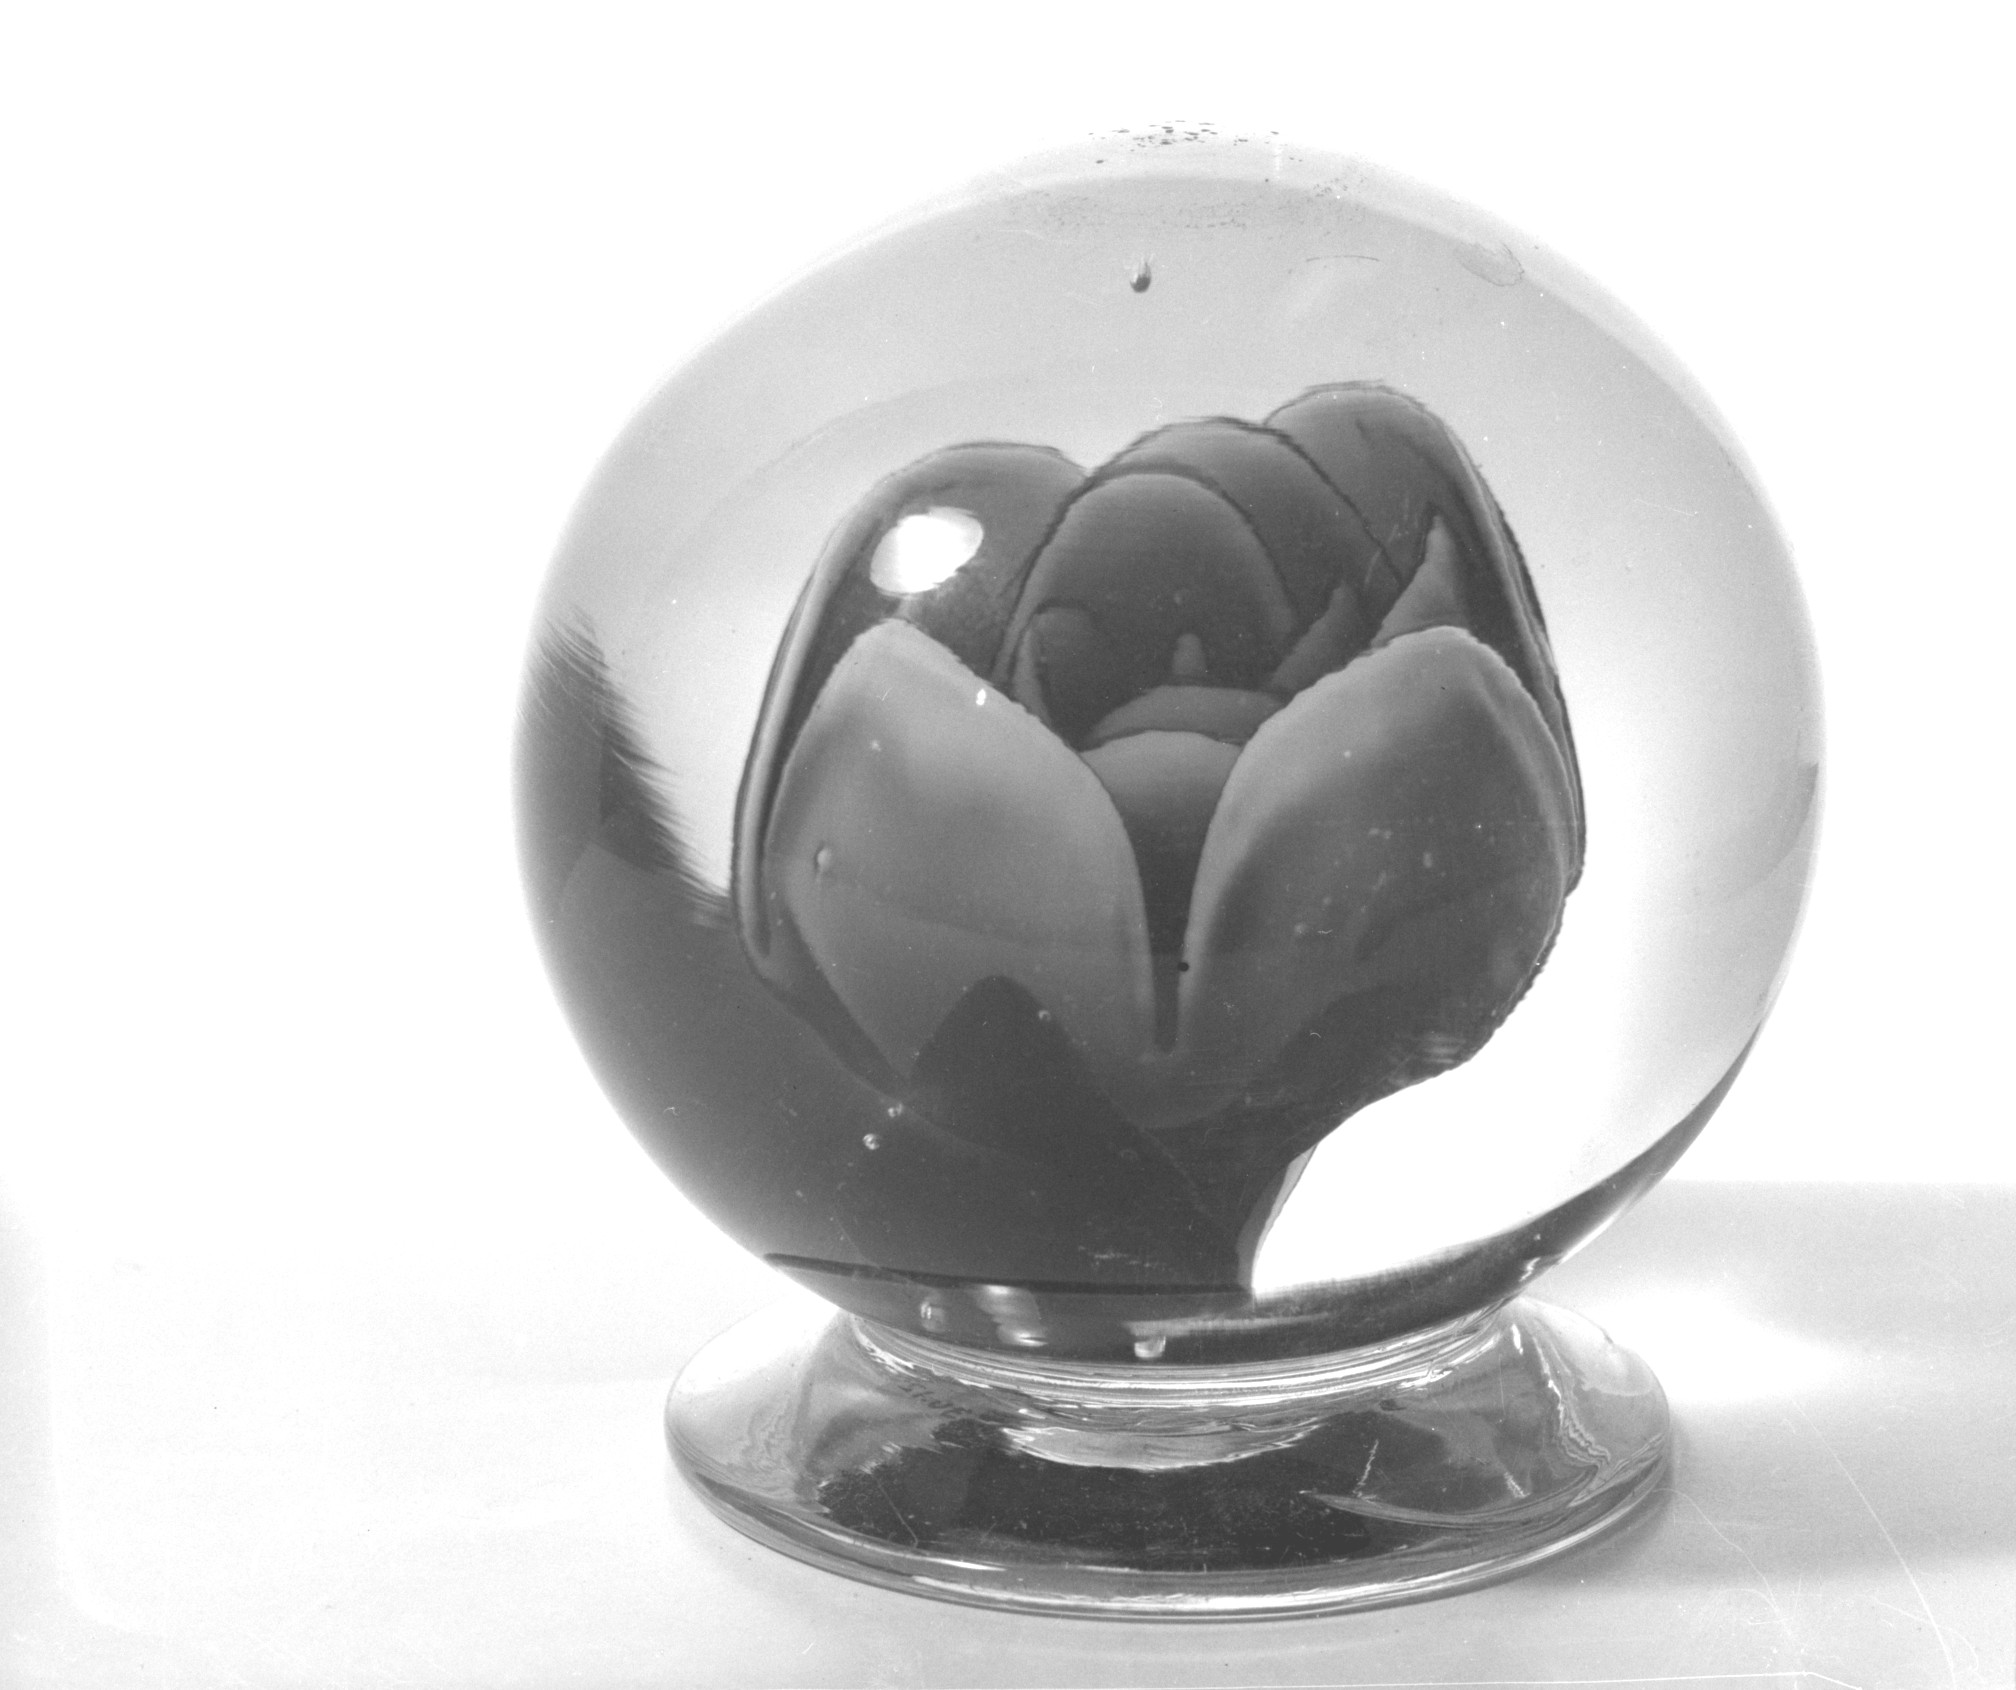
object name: paperweight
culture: american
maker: mount washington glass company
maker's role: maker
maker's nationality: american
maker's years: 1837-1958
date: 1870-1900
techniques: glassblowing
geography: united states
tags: flowers